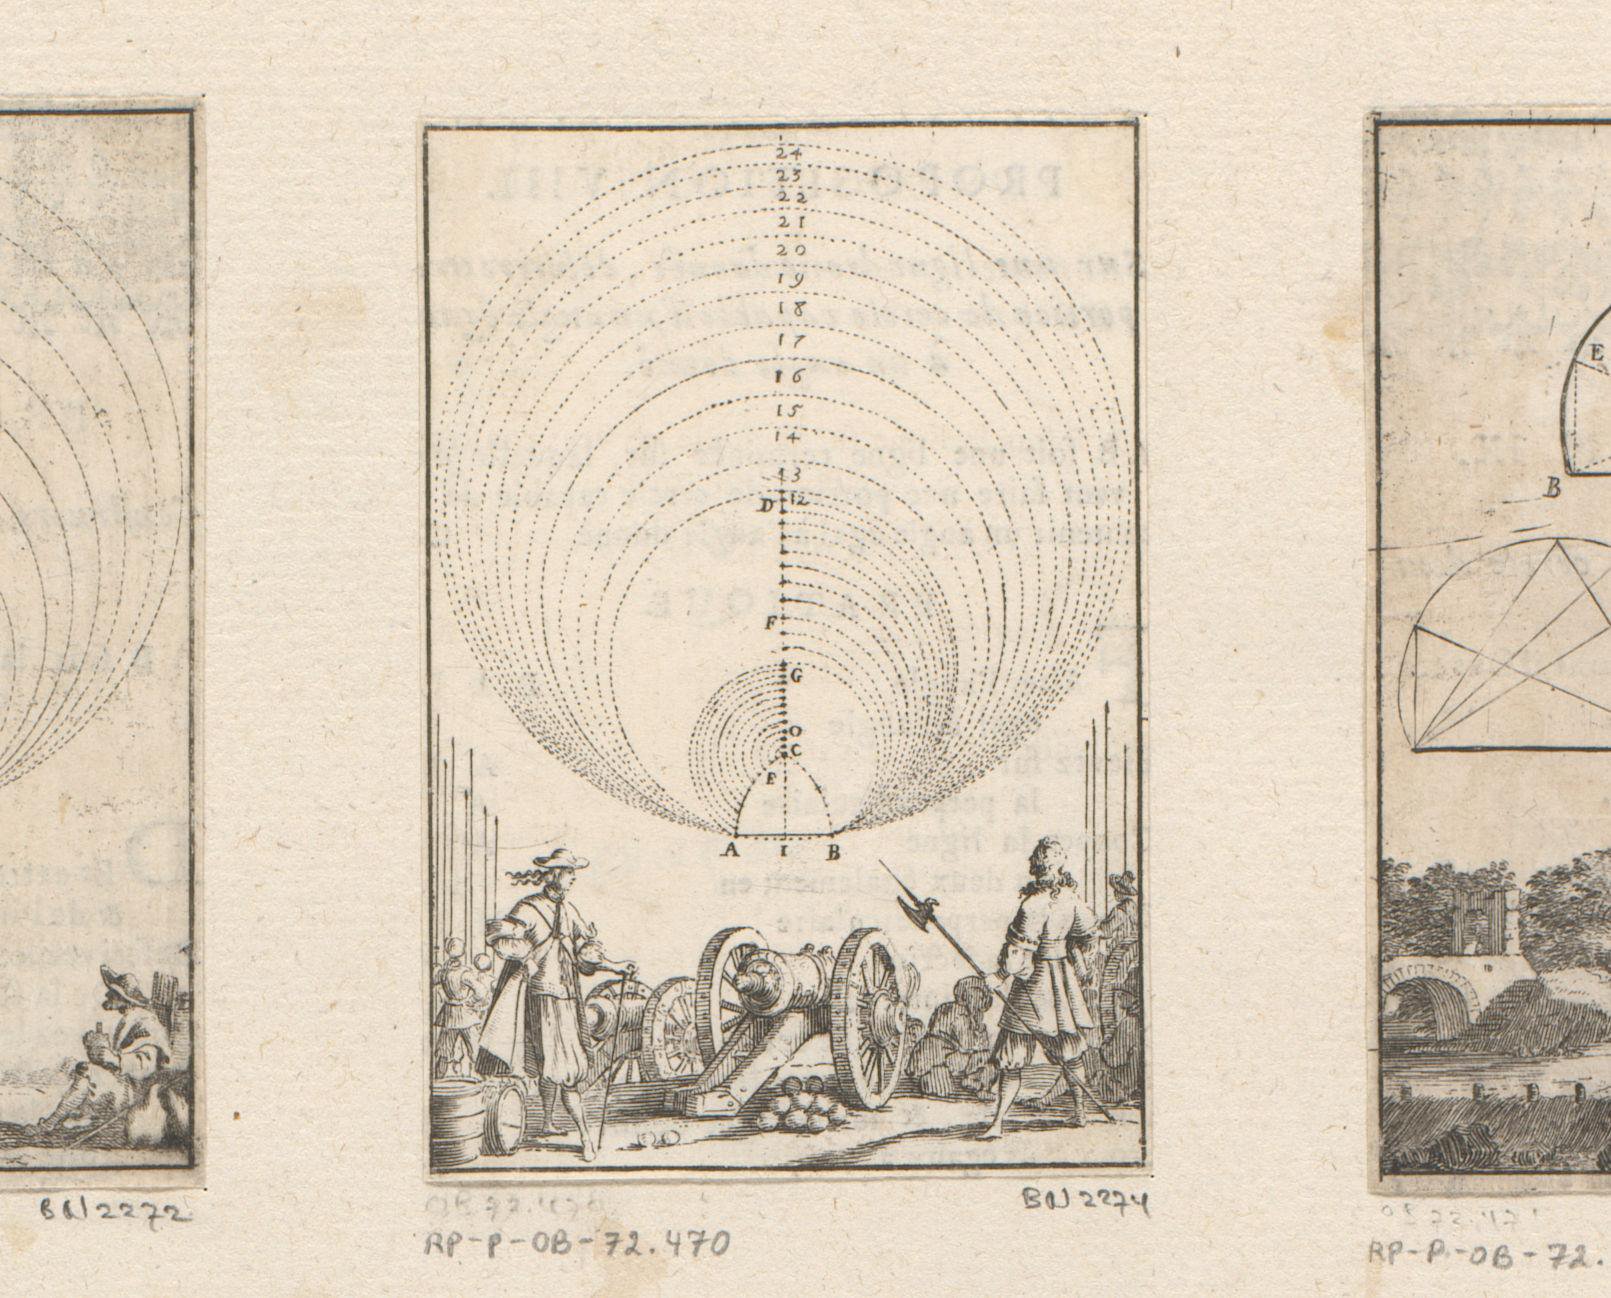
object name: print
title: Veelhoeken maken op een rechte lijn met onderaan kanonniers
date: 1669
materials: paper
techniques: etching, letterpress printing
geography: france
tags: firearms: cannon, planimetry, geometry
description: Prent uit: Pratique de la géometrie, sur le papier et sur le terrain. Avec un nouvel ordre et une méthode particulière. Parijs: Thomas Jolly, 1669.